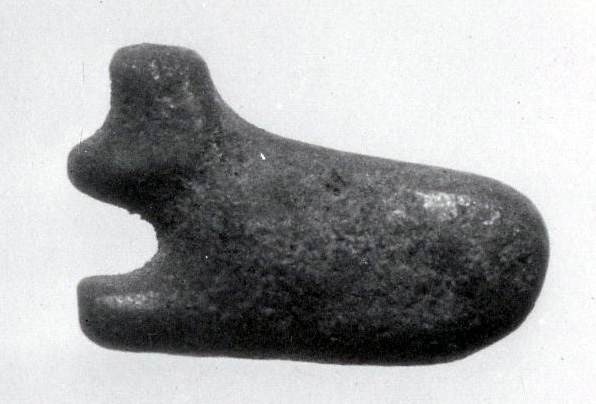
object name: amulet, cow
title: Amulet of a cow?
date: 306-30 BCE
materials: faience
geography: egypt